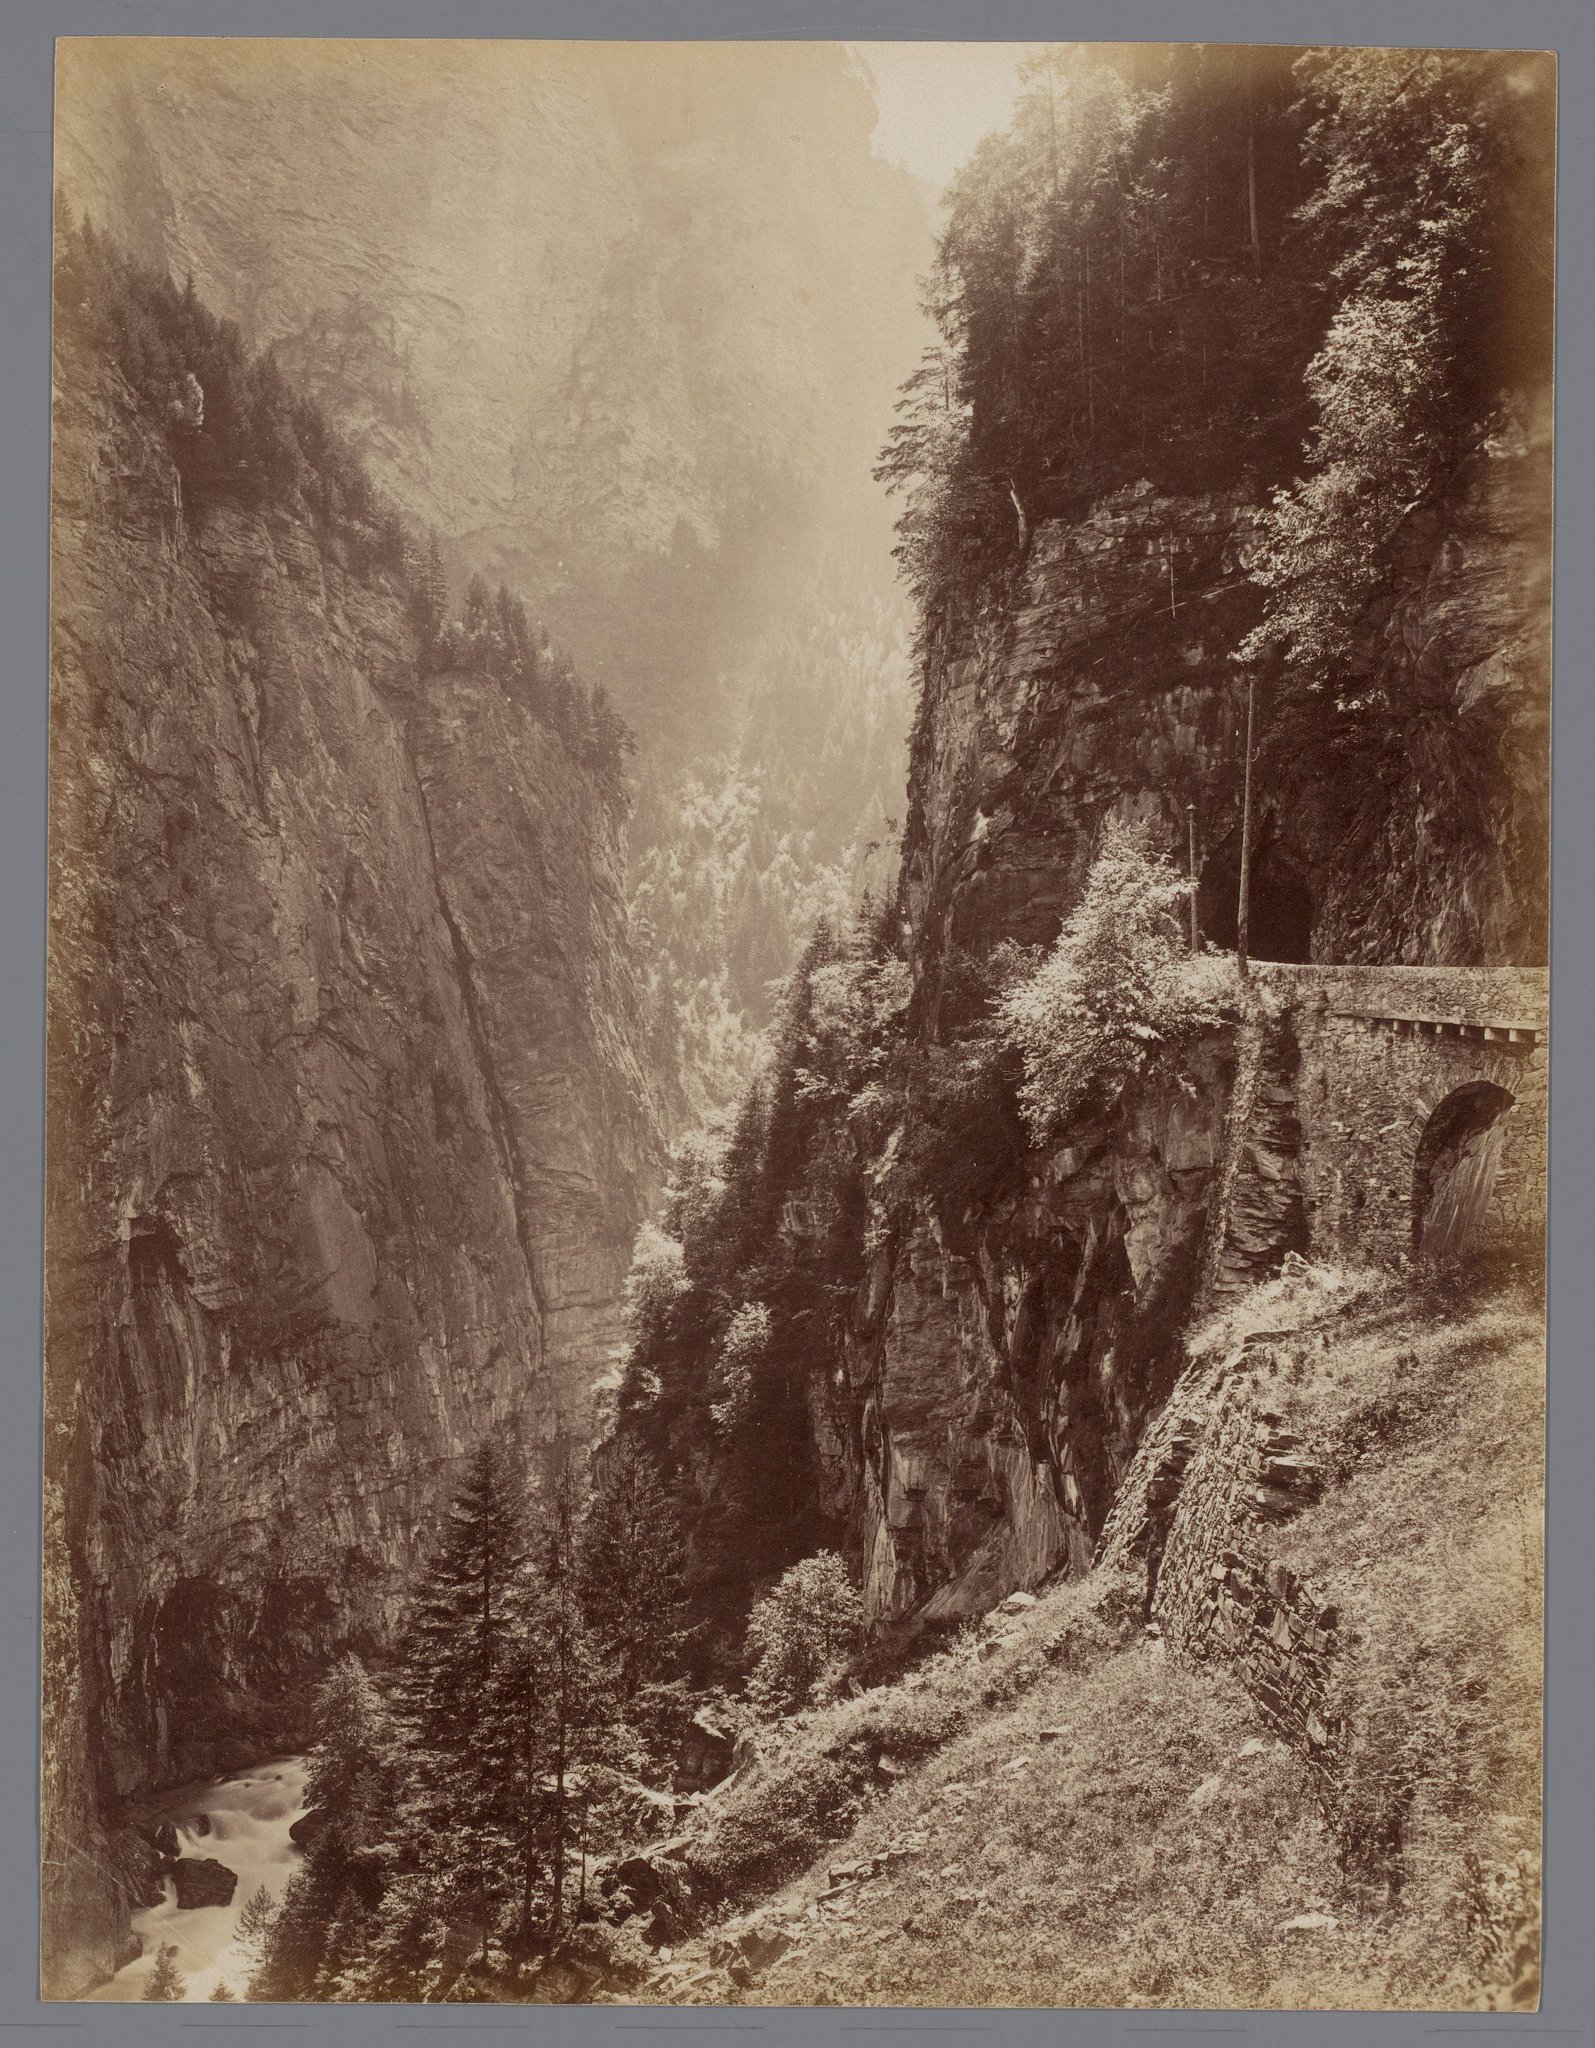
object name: photograph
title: "Trou Perdu", Via Mala, nabij Tuses (kanton Graubünden/Grisons), Zwitserland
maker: leon clément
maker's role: fotograaf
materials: paper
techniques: albumen print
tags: switzerland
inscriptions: number: ‘1083’, inscription: ‘13 june 99’, inscription: ‘ADOLF [sic] BRAUN SUCC.’, number: ‘244’, check stamp: ‘[...?] Ad. Braun & Cie//Braun Clement [...?]’, inscription: ‘trou perdu’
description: "Trou Perdu", Via Mala, nabij Tuses (kanton Graubünden/Grisons), Zwitserland. Plaatsbepaling op grond van gravure van William Henry Bartlett "Galerij in het "Trou Perdu" nabij Tuses (Grisons), rond 1850, 183 X 120 mm.